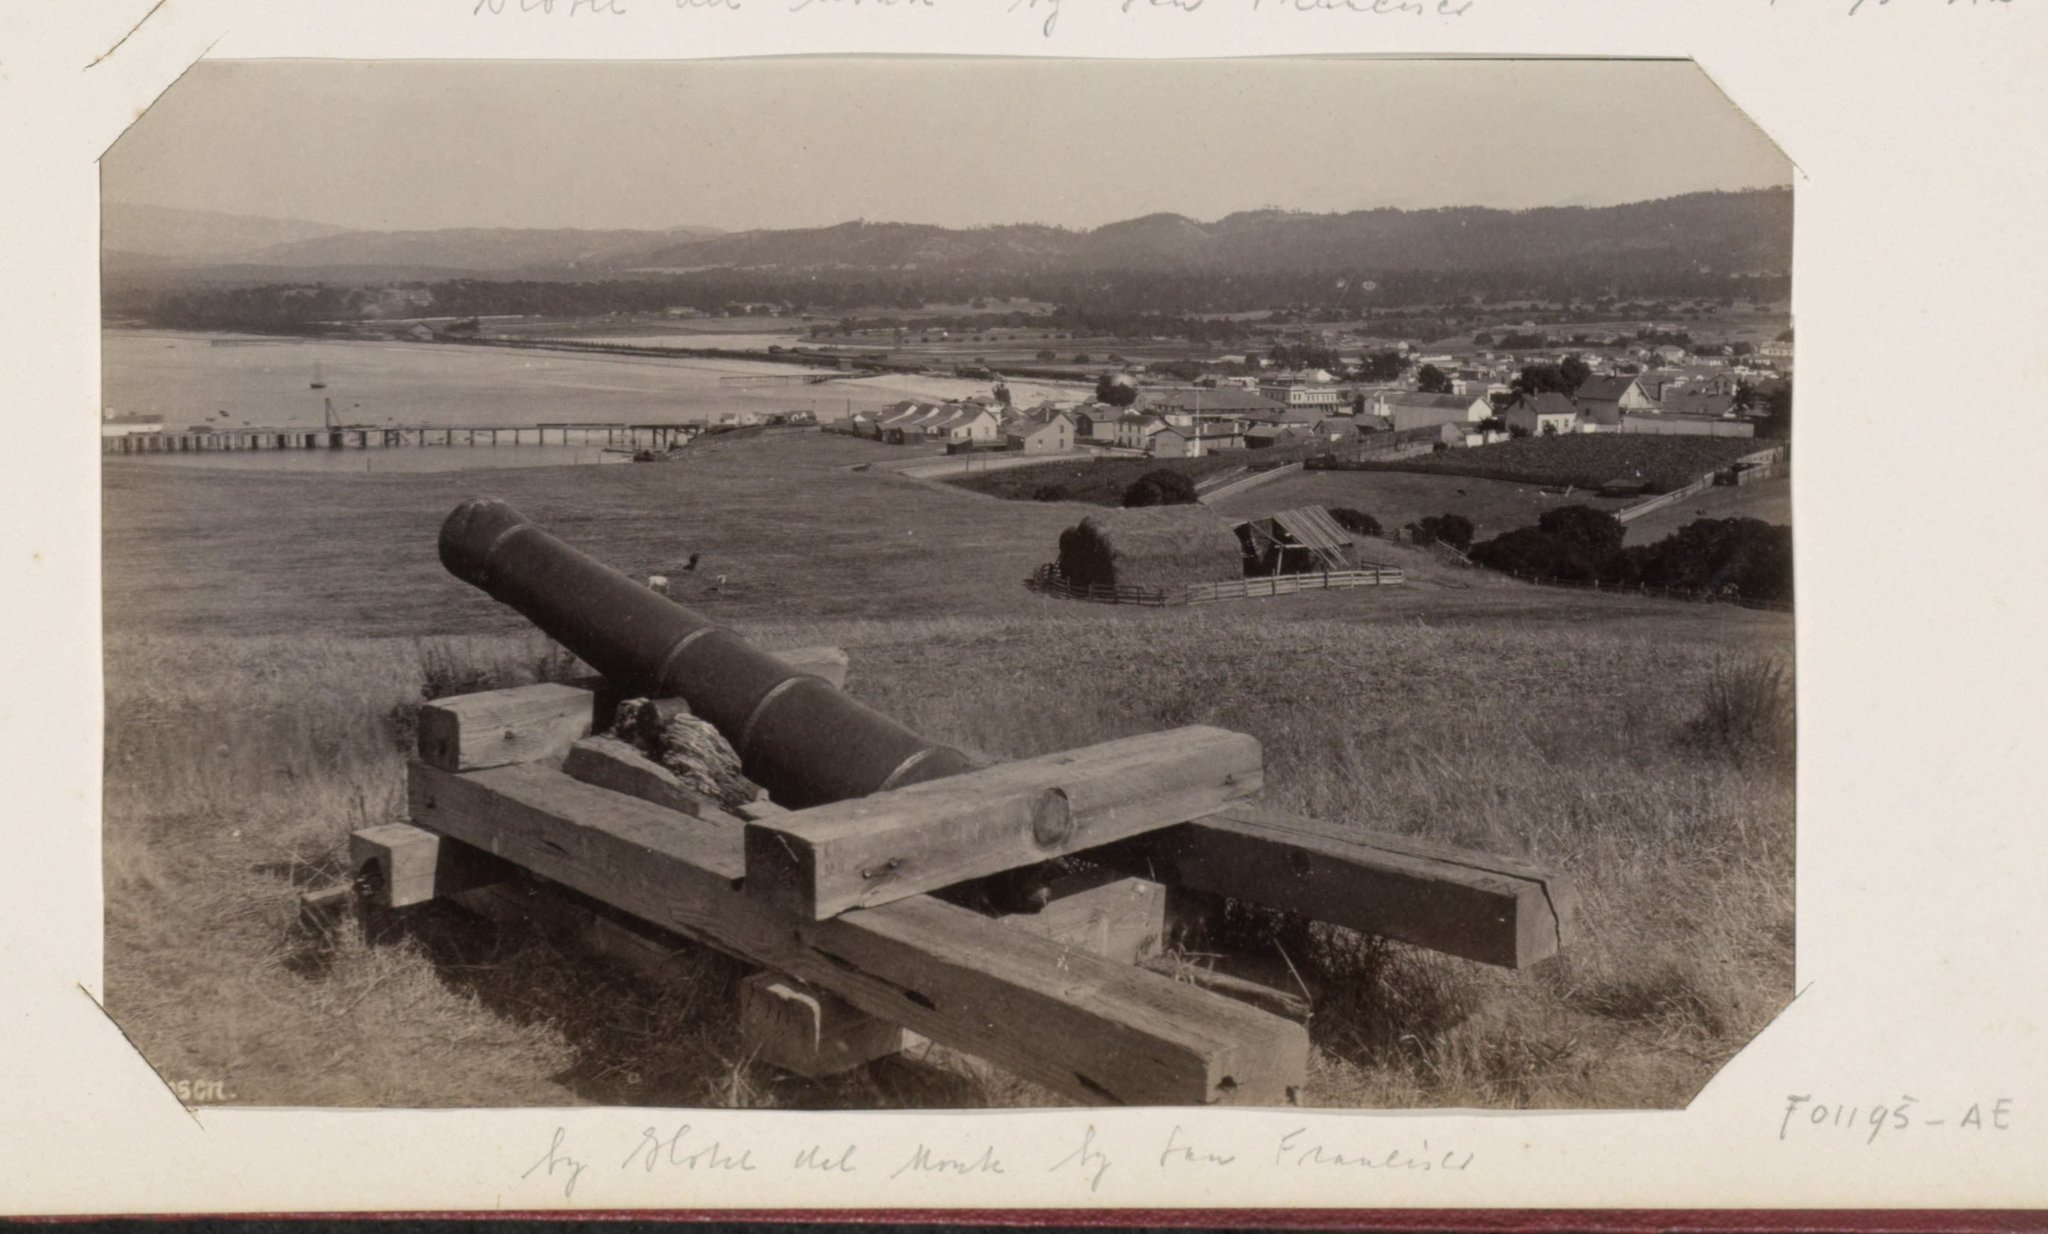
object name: photograph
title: Kanon bij Hotel del Monte in San Francisco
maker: johnson (fotograaf)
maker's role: fotograaf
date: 1860-1900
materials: cardboard, paper, photographic support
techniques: albumen print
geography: san francisco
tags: firearms: cannon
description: Onderdeel van Fotoalbum van een reis door de Verenigde Staten, Honolulu, Nederlands-Indië, Aden, Zanzibar en Zuidelijk Afrika.